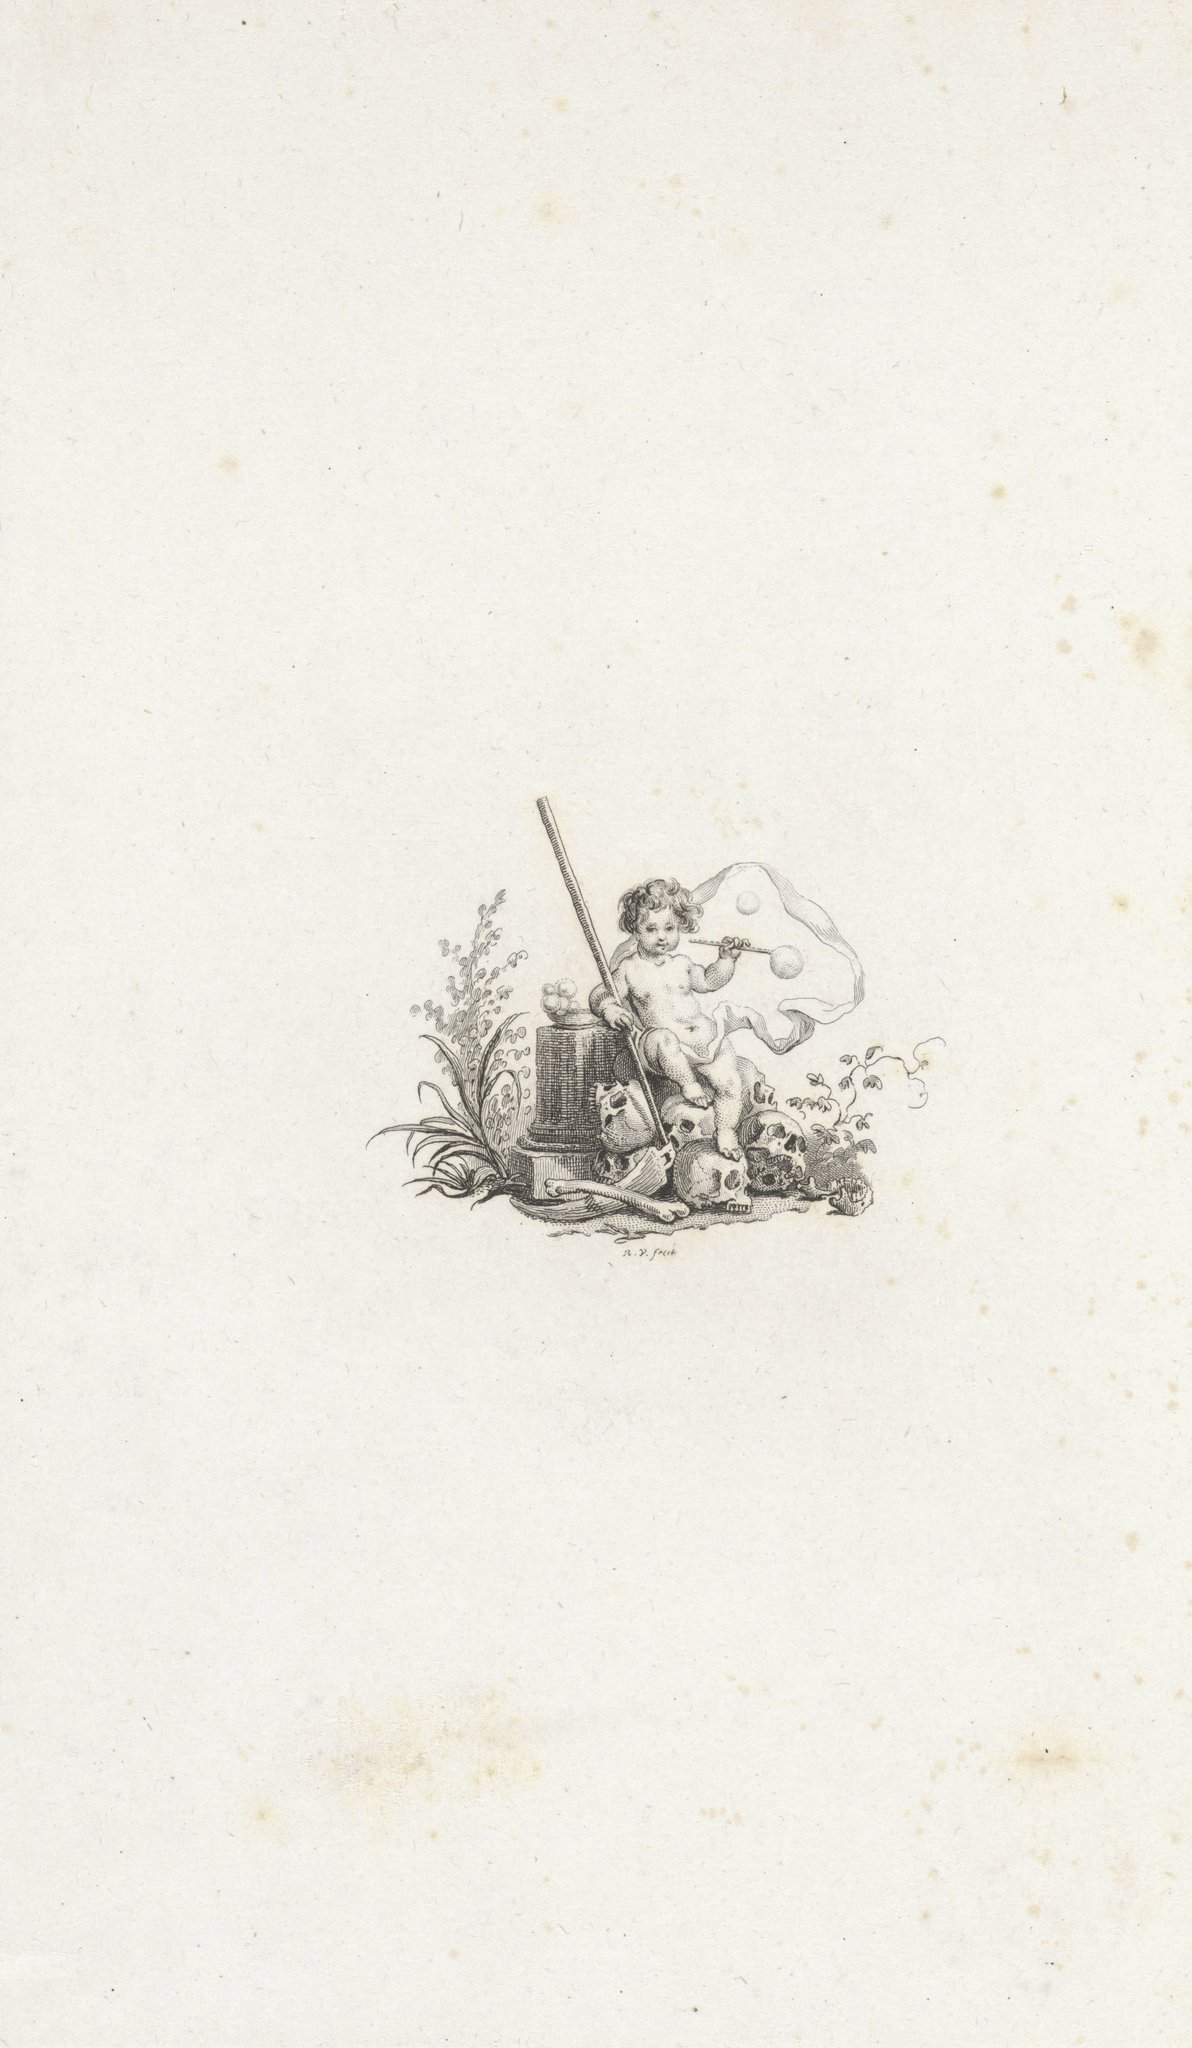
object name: print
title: Vignet met een bellenblazende putto op een berg van schedels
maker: reinier vinkeles (i)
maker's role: draughtsman, print maker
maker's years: 1741-1816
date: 1751-1816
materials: paper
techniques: etching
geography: amsterdam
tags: skull as symbol of 'vanitas', (children or putti) blowing bubbles, 'homo bulla' ~ scene symbolizing 'vanitas'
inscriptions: collector's mark: Lugt 240